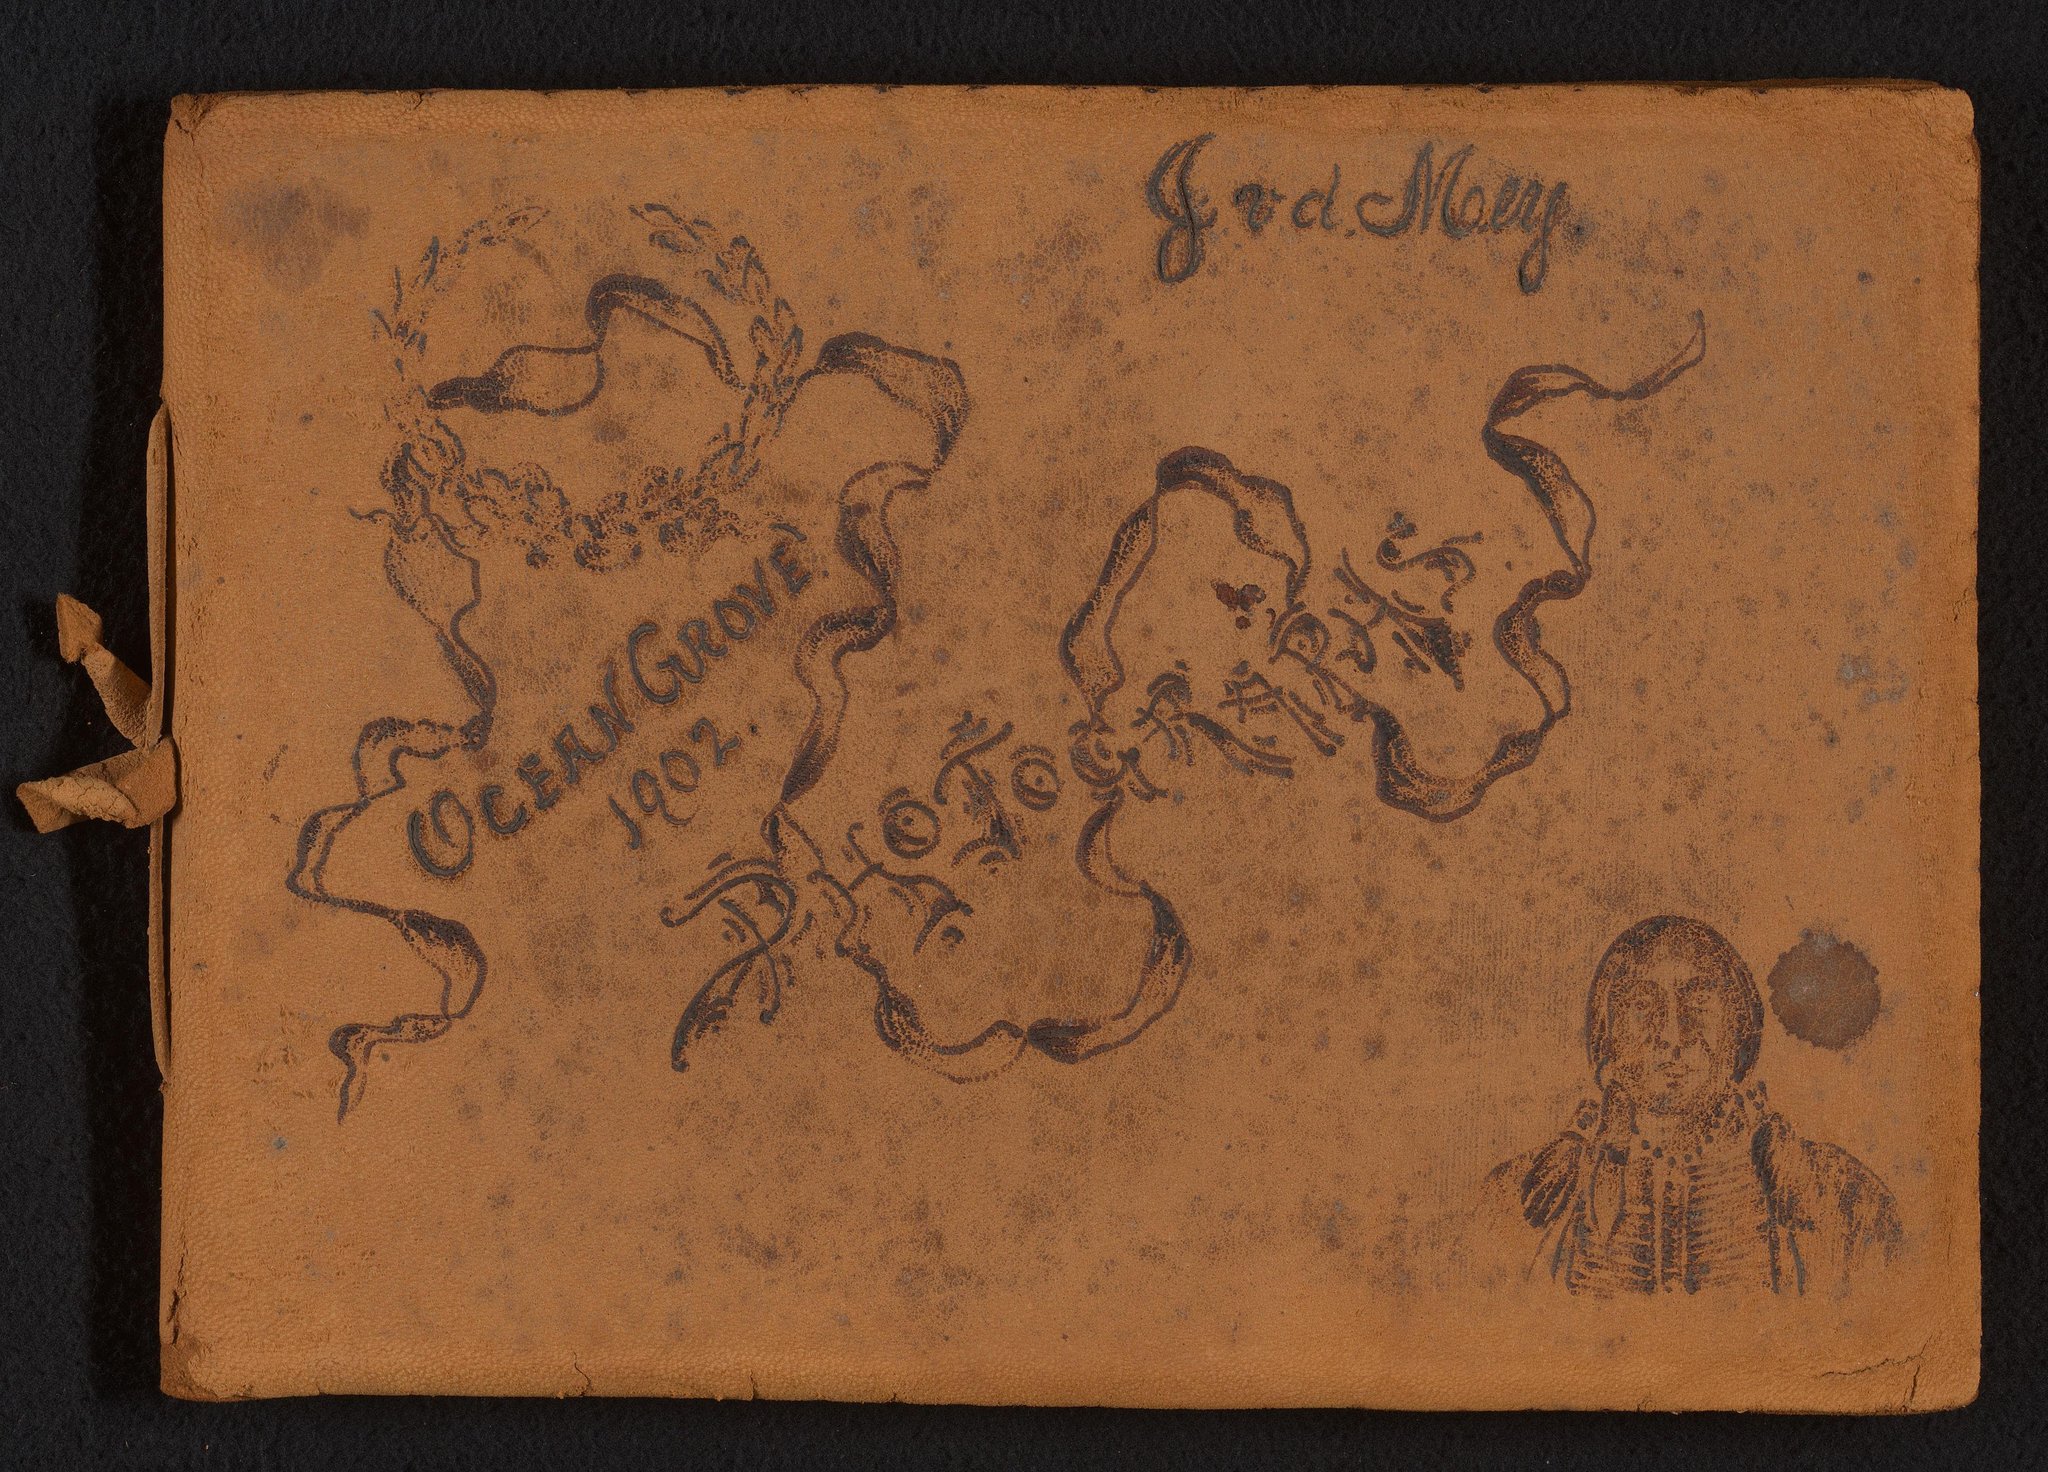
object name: scrapbook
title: Photographs J. vd Mey Ocean Grove 1902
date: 1902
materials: paper, ink, leather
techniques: engraving, gelatin silver print, pen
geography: netherlands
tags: garland, wreath, indigenous peoples of north america, outing, pleasure trip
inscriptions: signature, date and inscription: ‘J. vd. Mey/ Ocean Grove/ 1902/ Photographs’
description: Album bevat 48 albumbladen met 95 foto's, die vermoedelijk zijn genomen door Jan van der Mey tijdens een reis per stoomboot (uitgevoerd door Red Star Line) vanuit Noord-Amerika naar Nederland waar familie wordt bezocht. Op de foto's is met name zijn vrouw Mary te zien, die mogelijk de samensteller is van het album, in onder andere Scheveningen, Veghel, Tiel, Niagara Falls en hun woonplaats Ottawa Beach.